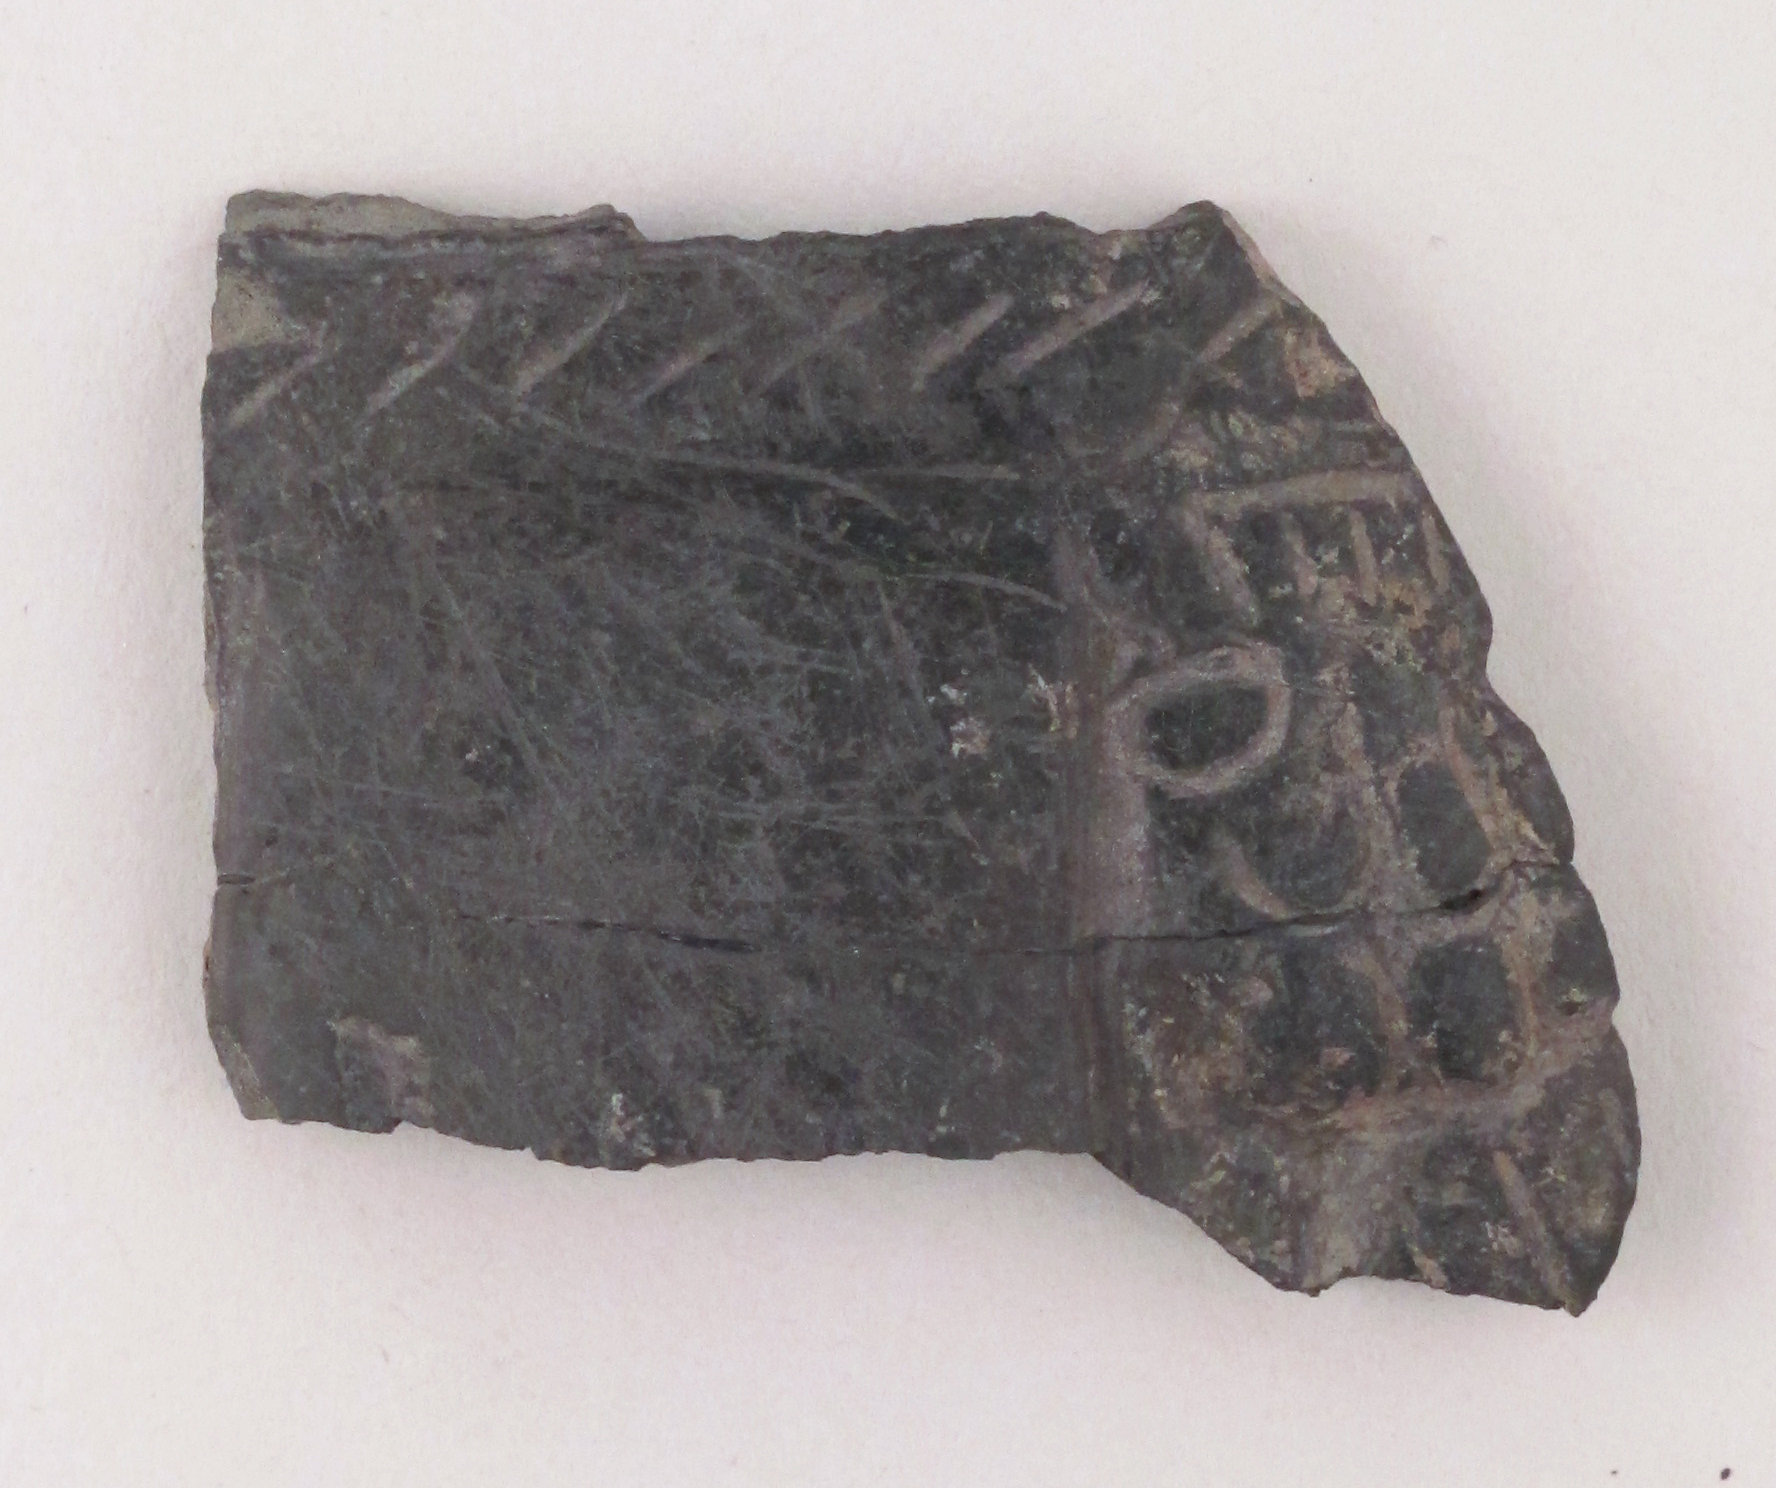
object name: vase fragment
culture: etruscan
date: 575-550 BCE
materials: terracotta